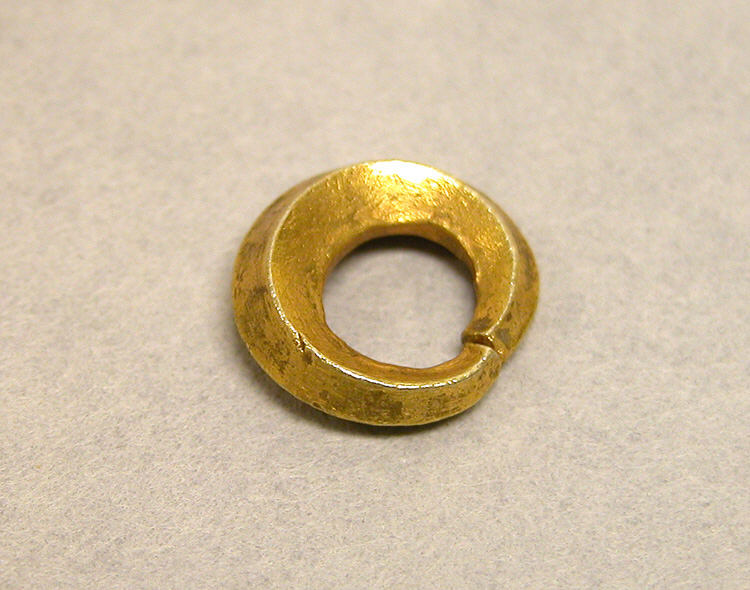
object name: pair of ear ornament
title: Pair of Ear Ornaments, Lunates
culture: indonesian, central java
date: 701-1200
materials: gold